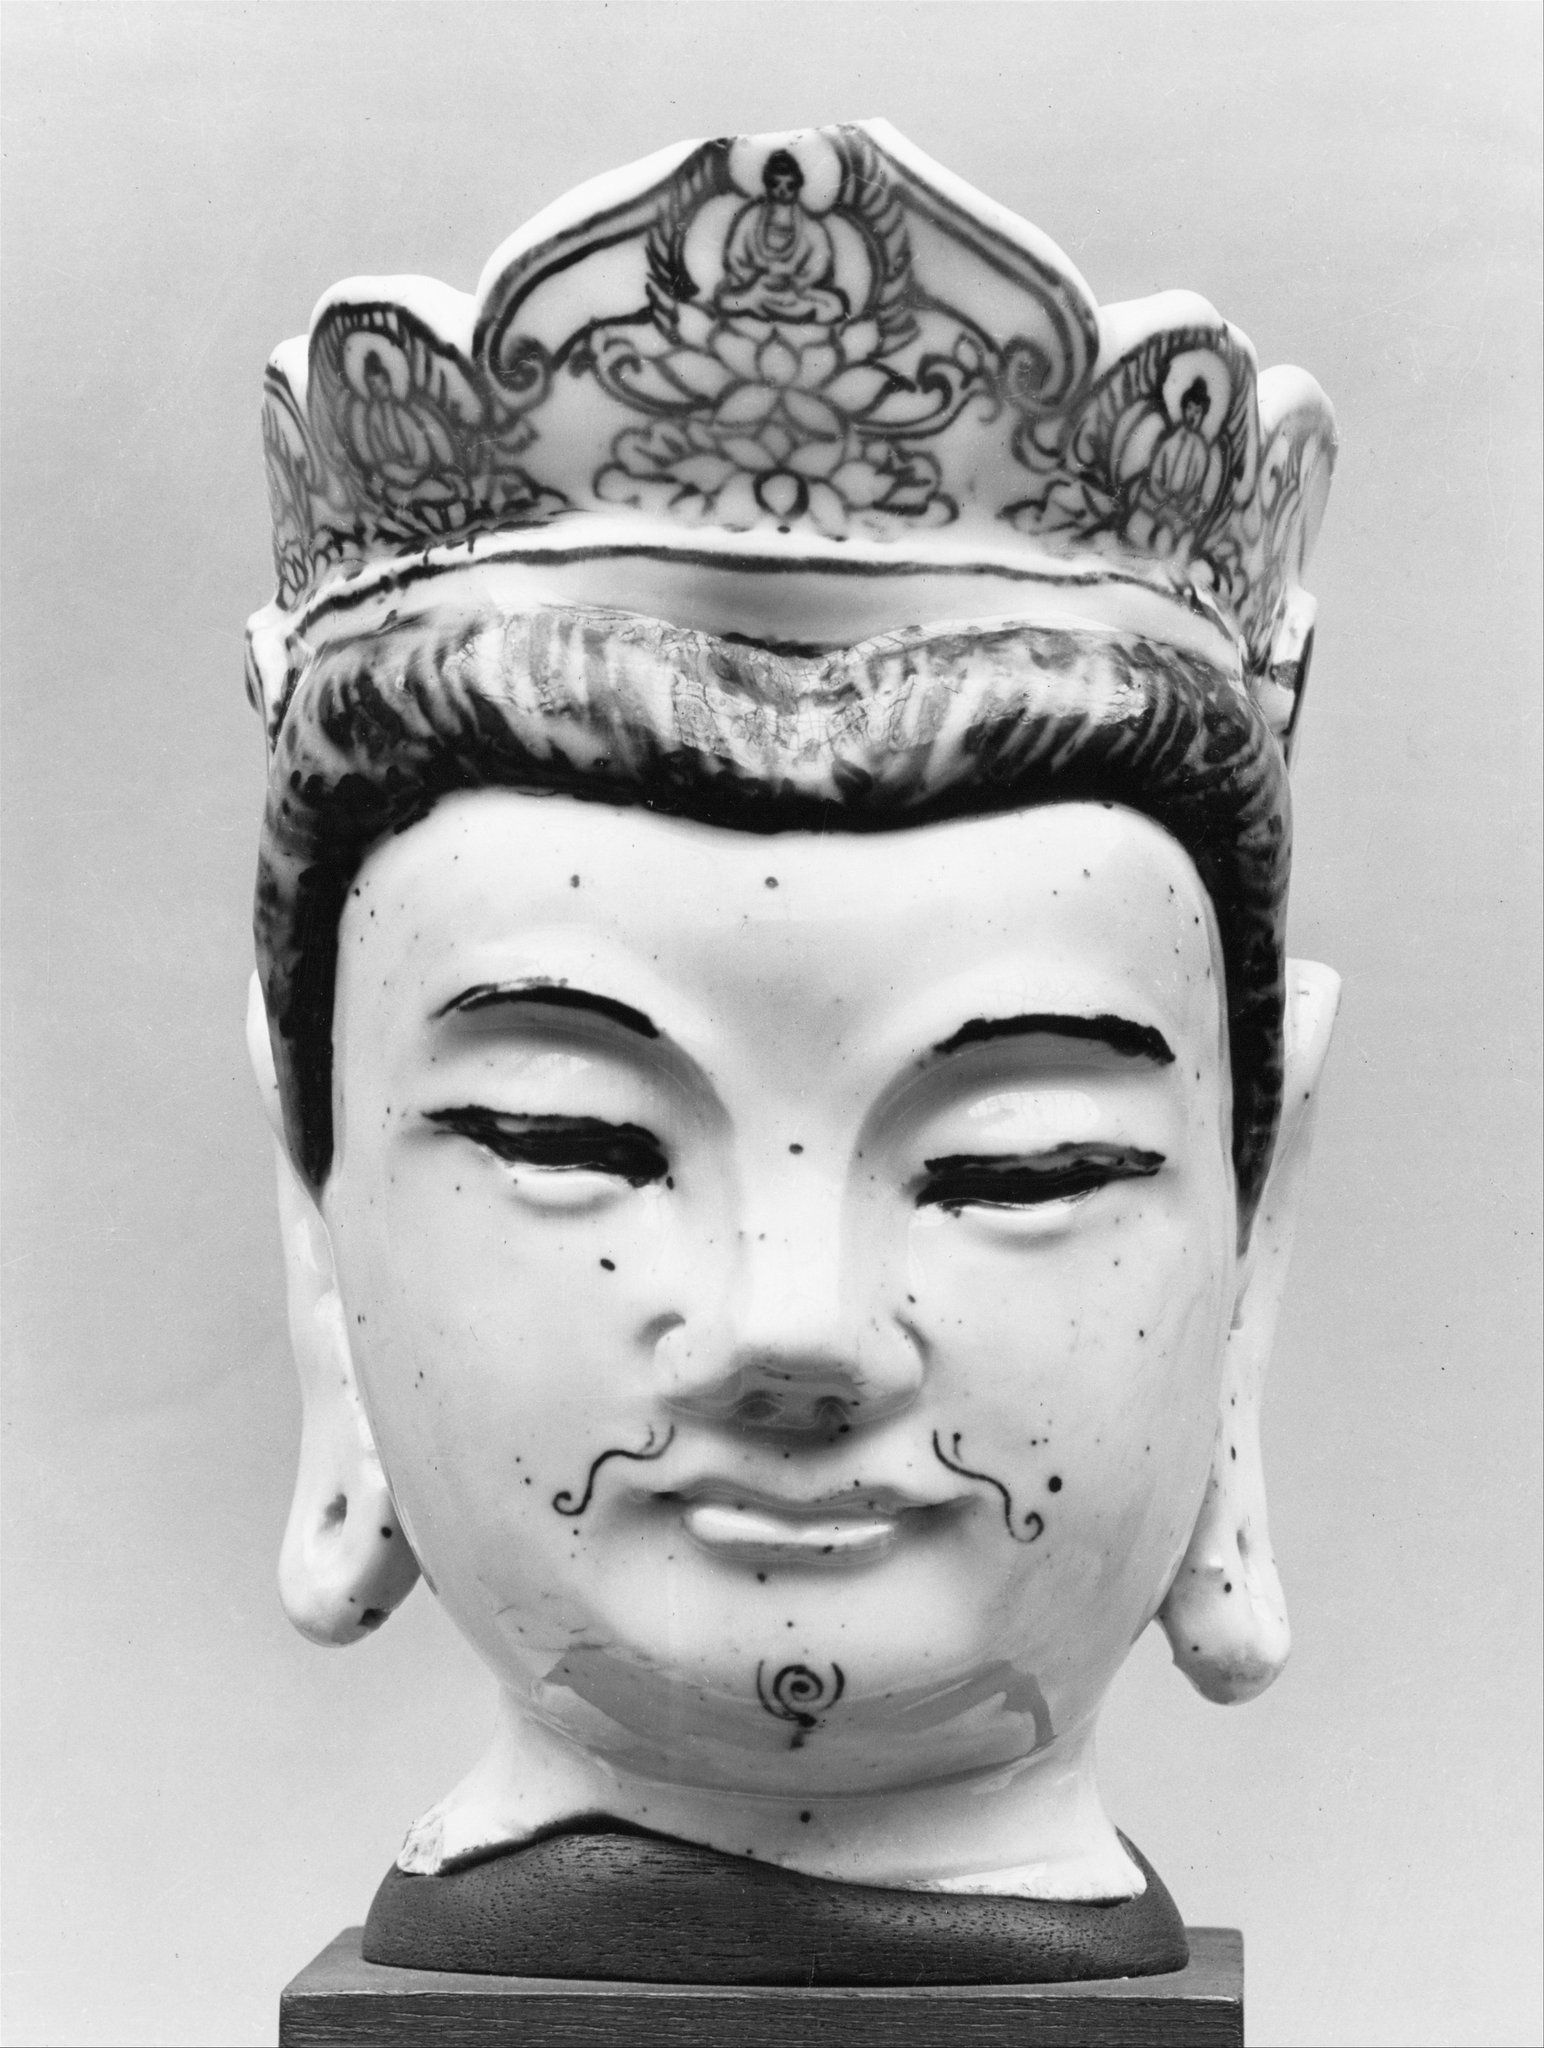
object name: head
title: Head of Guanyin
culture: chinese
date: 1301-1400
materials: porcelain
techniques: painting, underglaze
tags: heads,bodhisattvas